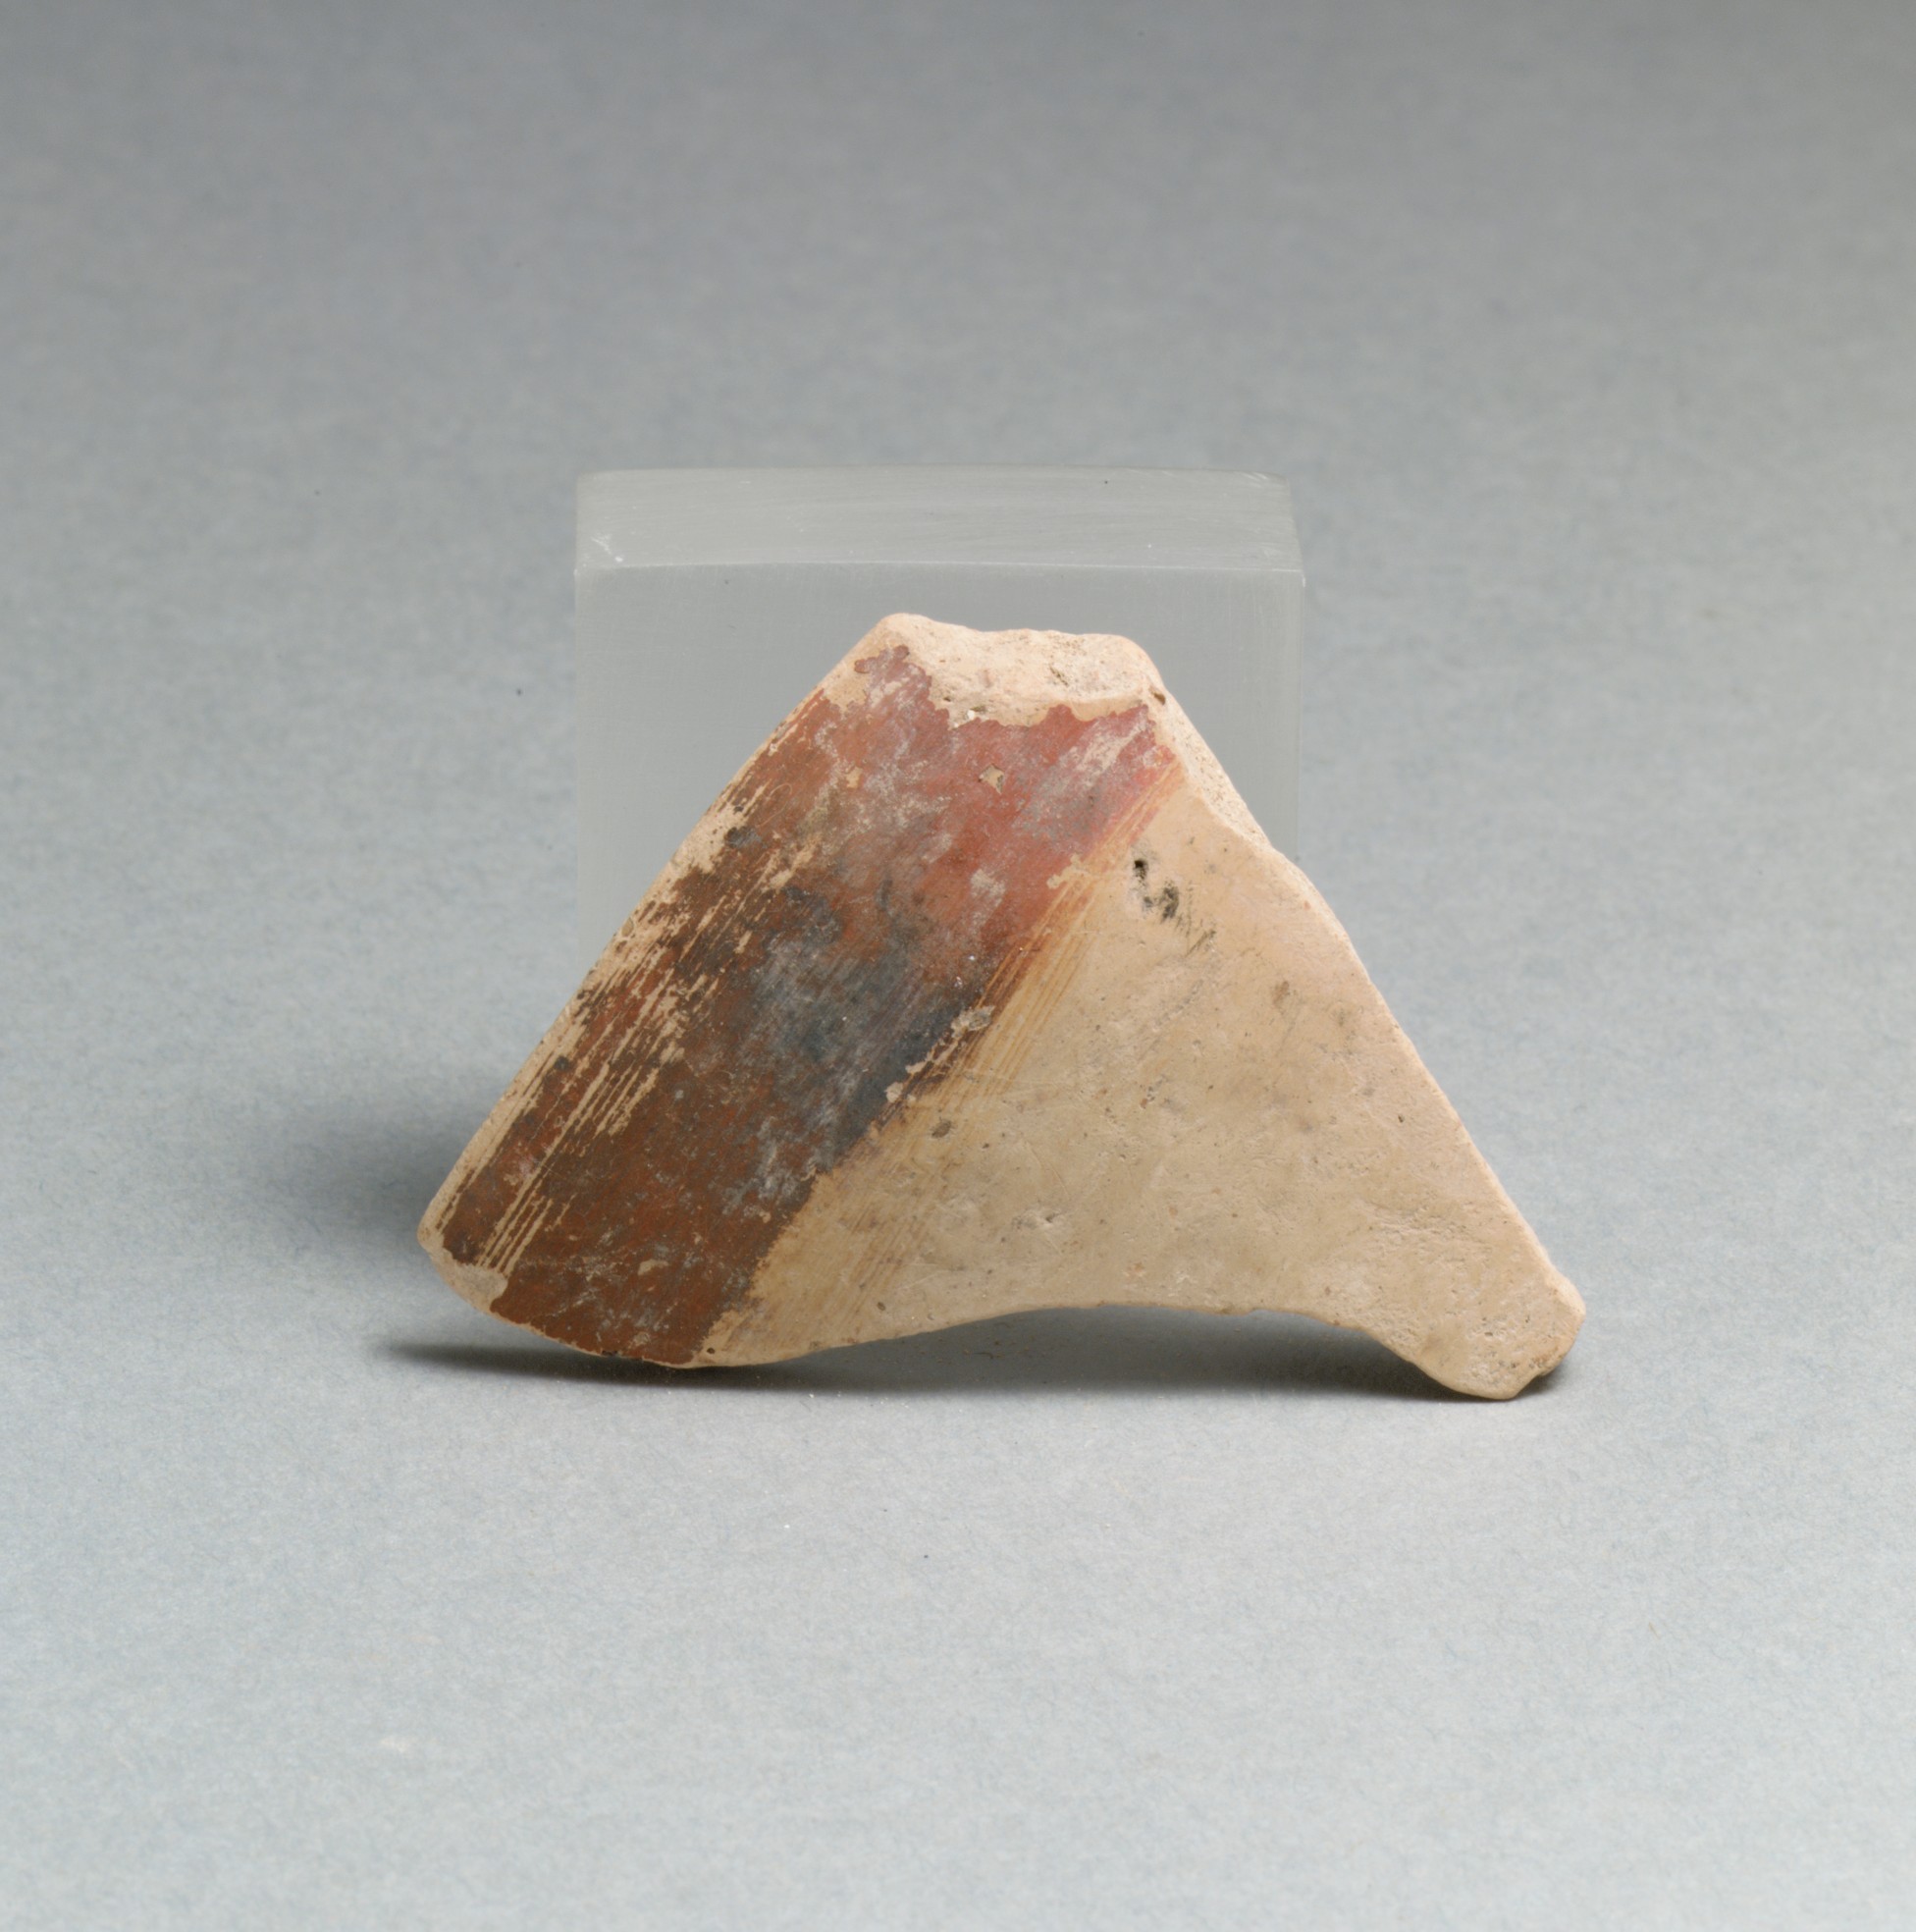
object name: vase fragment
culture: minoan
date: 2600-2000 BCE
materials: terracotta